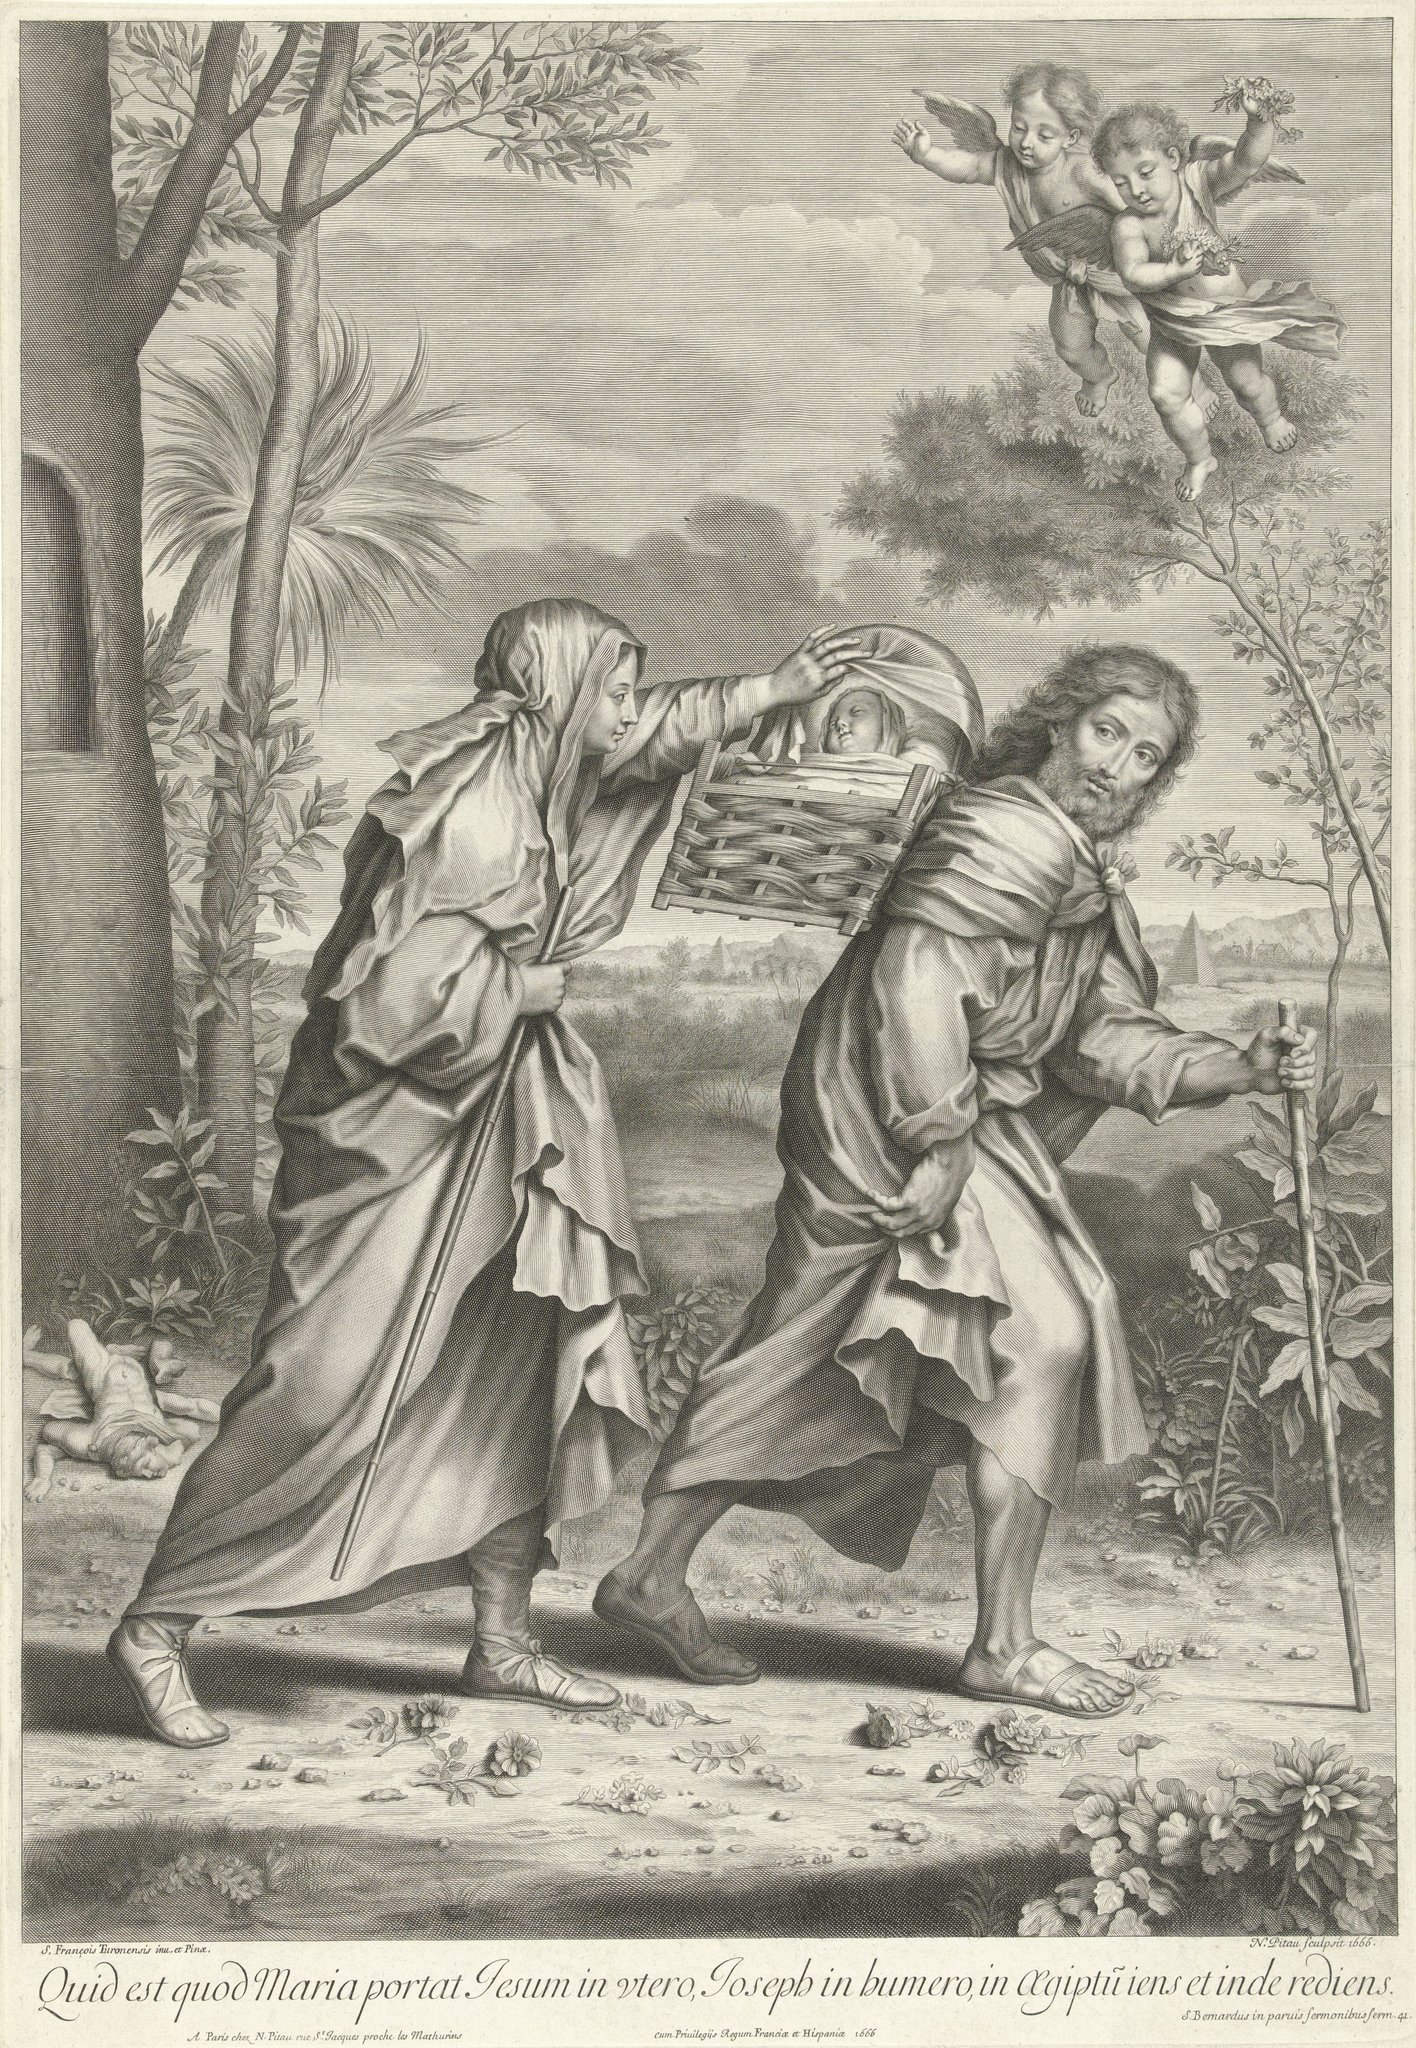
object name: print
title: Vlucht naar Egypte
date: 1666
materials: paper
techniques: engraving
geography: paris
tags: the flight into egypt: mary, joseph, the child (and sometimes others) on their way; mary usually riding on an ass, carrying a child on the back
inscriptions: collector's mark: Lugt 240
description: De Heilige Familie vlucht naar Egypte en loopt door een landschap met pyramiden. Jozef draagt het Christuskind in een mand op zijn rug. In de lucht twee engelen met bloemenkransen. In de marge een onderschrift in het Latijn.